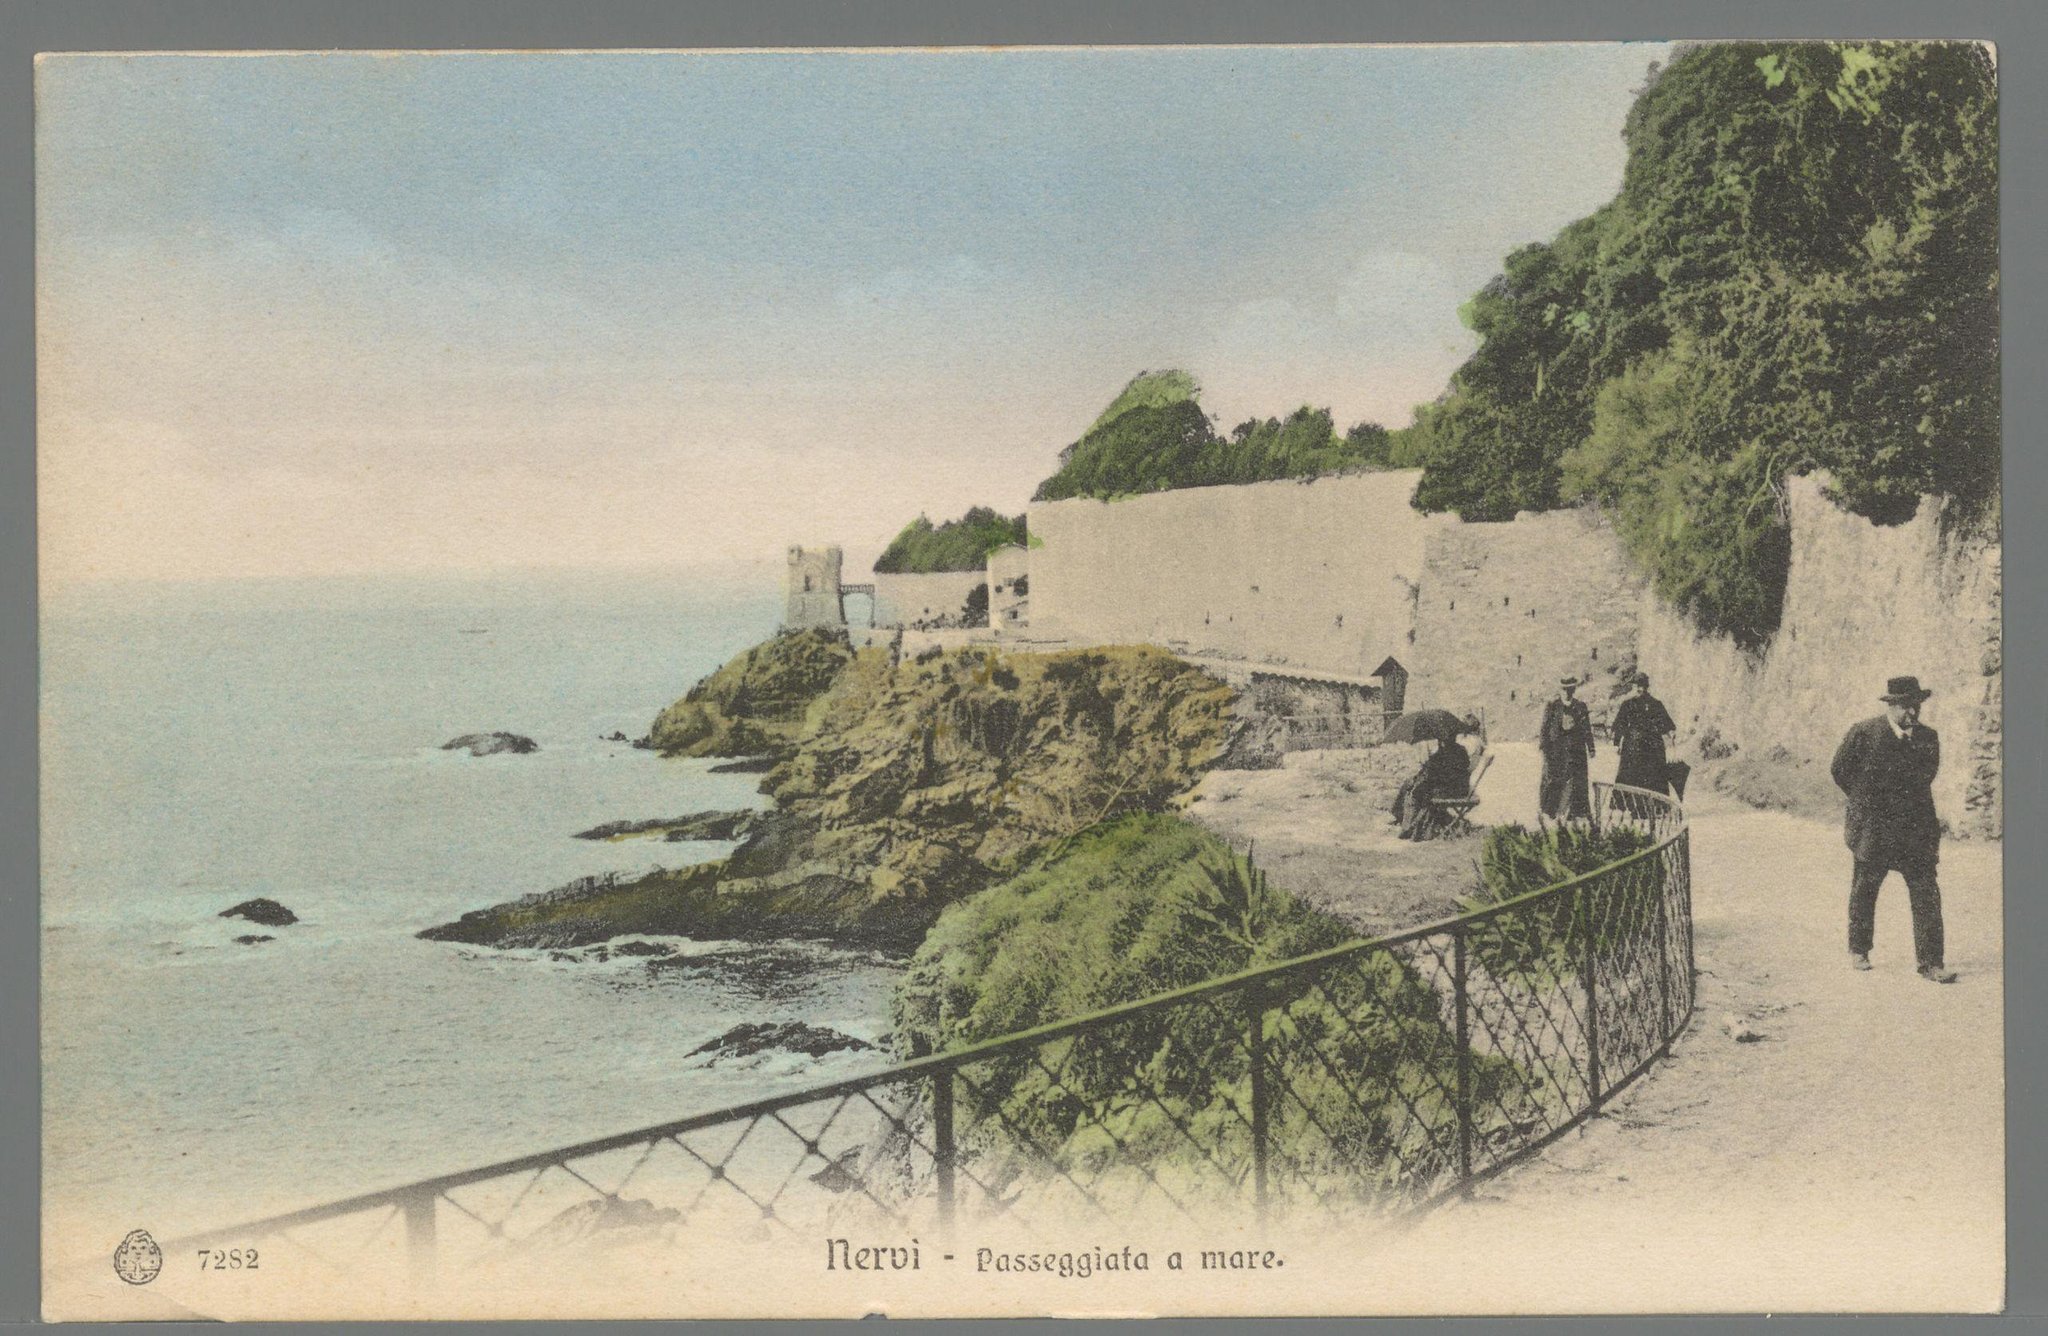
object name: photomechanical print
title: Nervi. Passeggiata a mare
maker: Anonymous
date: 1905-1909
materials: cardboard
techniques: photograph, lithograph, writing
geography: nervi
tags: road, path (+ four persons or more ~ traffic and transport), rocky coast, sea (seascape)